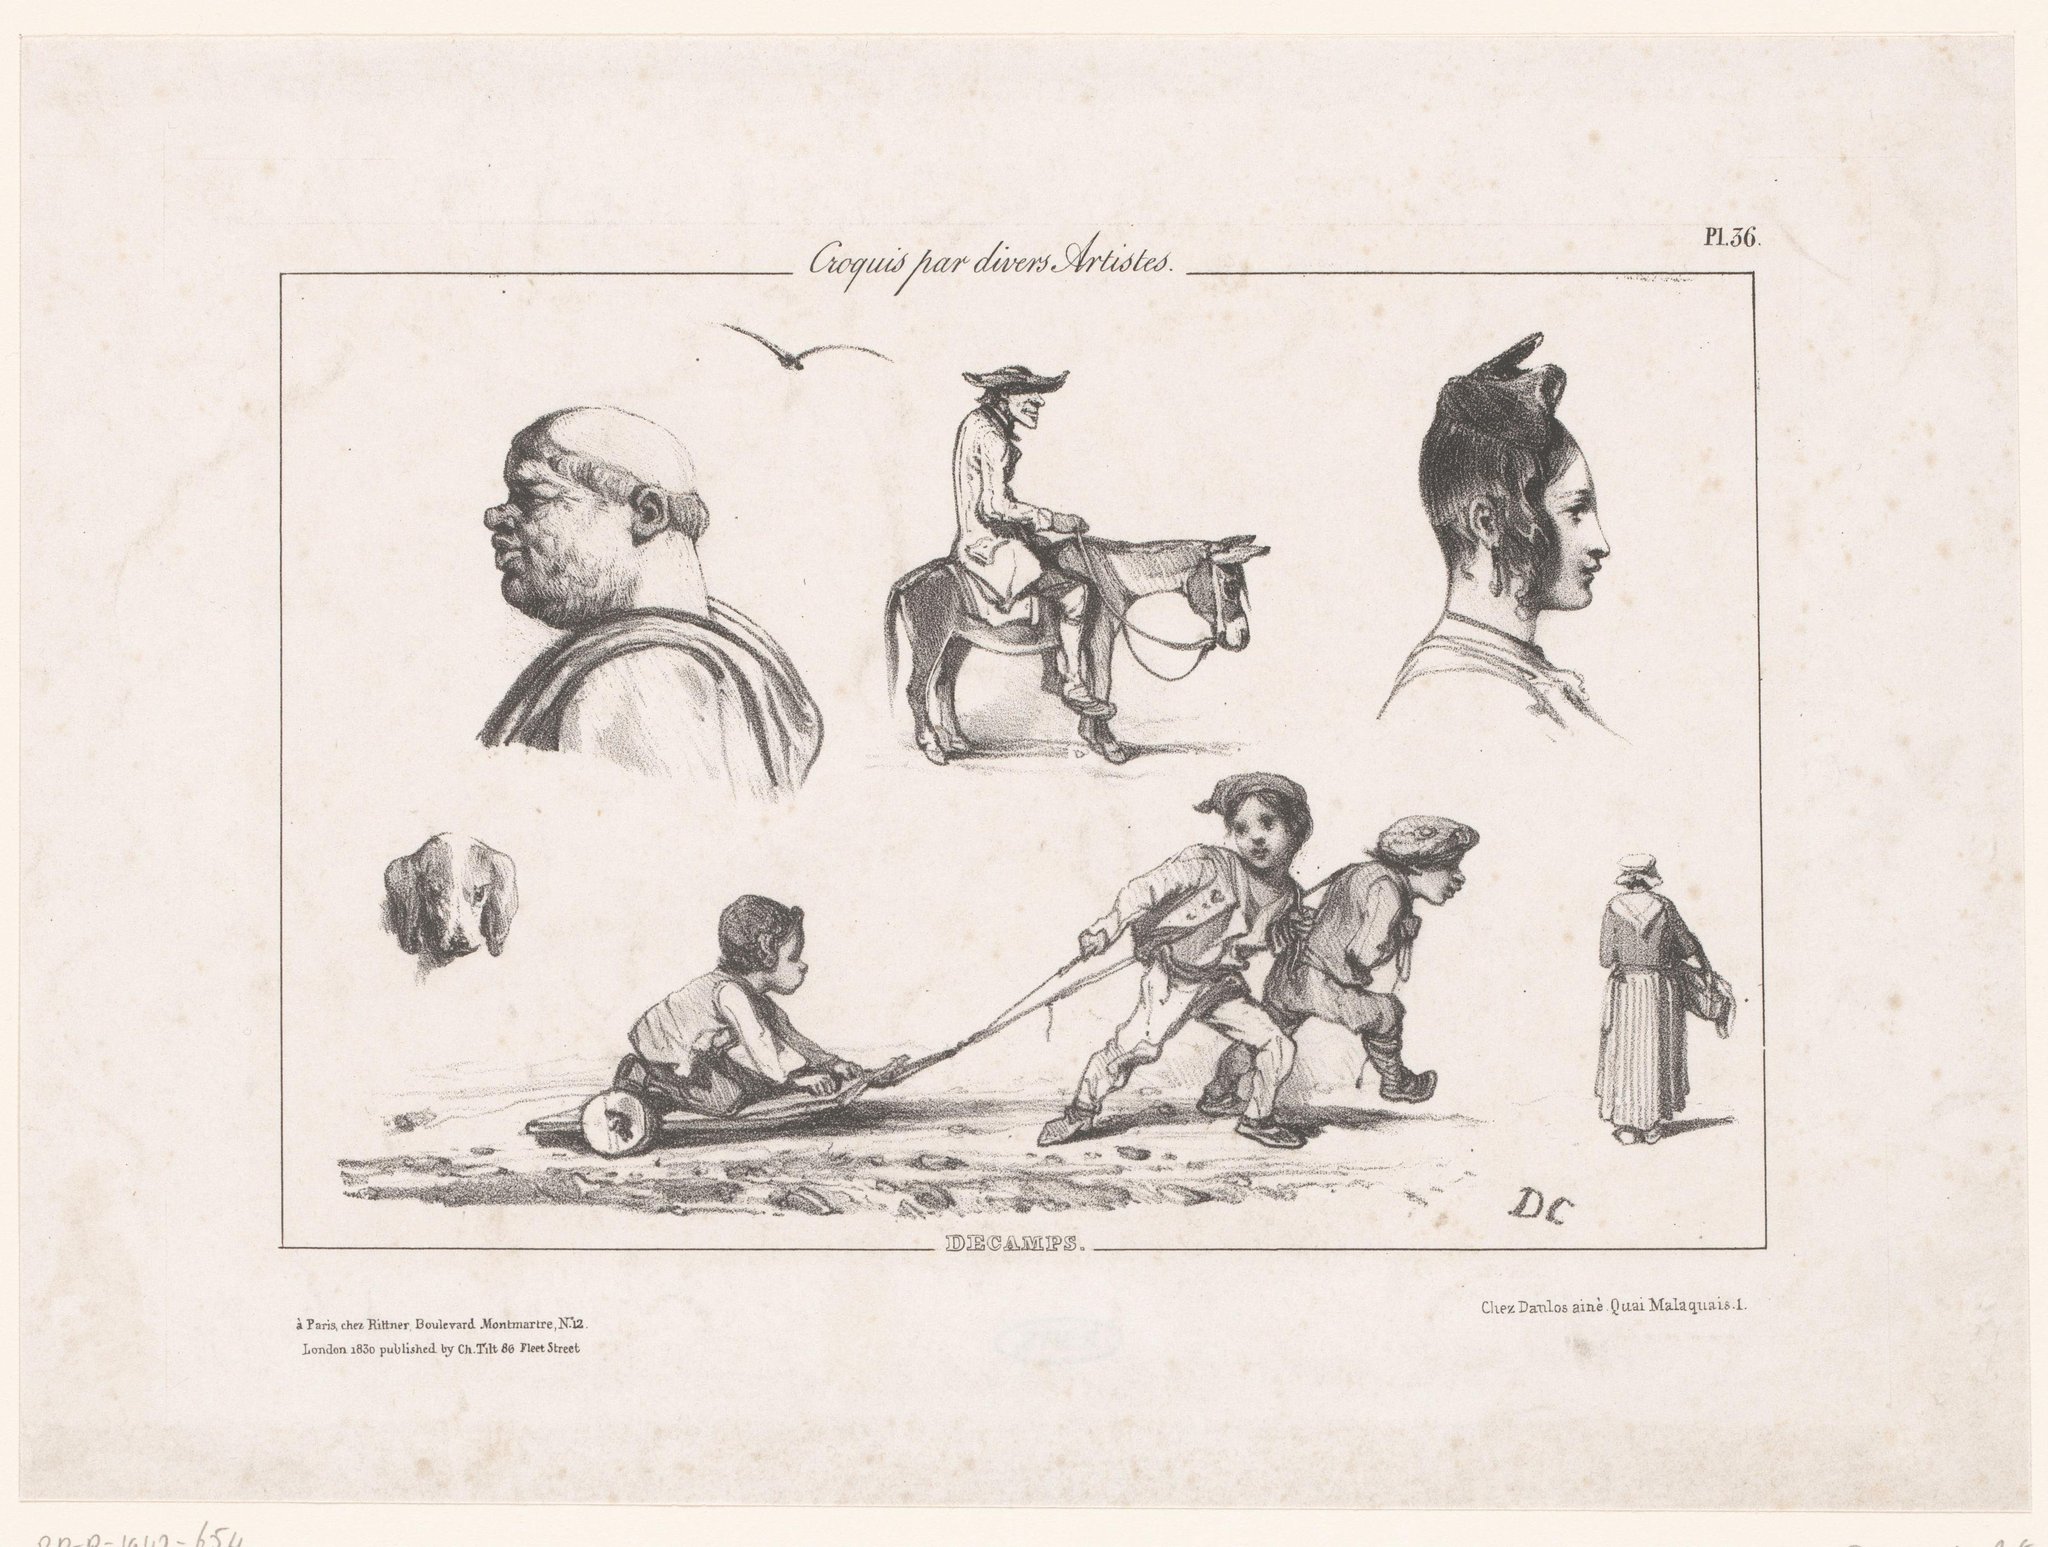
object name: print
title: Croquis par divers artistes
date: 1830-1831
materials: paper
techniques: lithograph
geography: paris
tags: riding a horse, ass, or mule; rider, horseman, monk(s), friar(s), (playing with) wheeled vehicles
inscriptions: collector's mark: Lugt 2228a